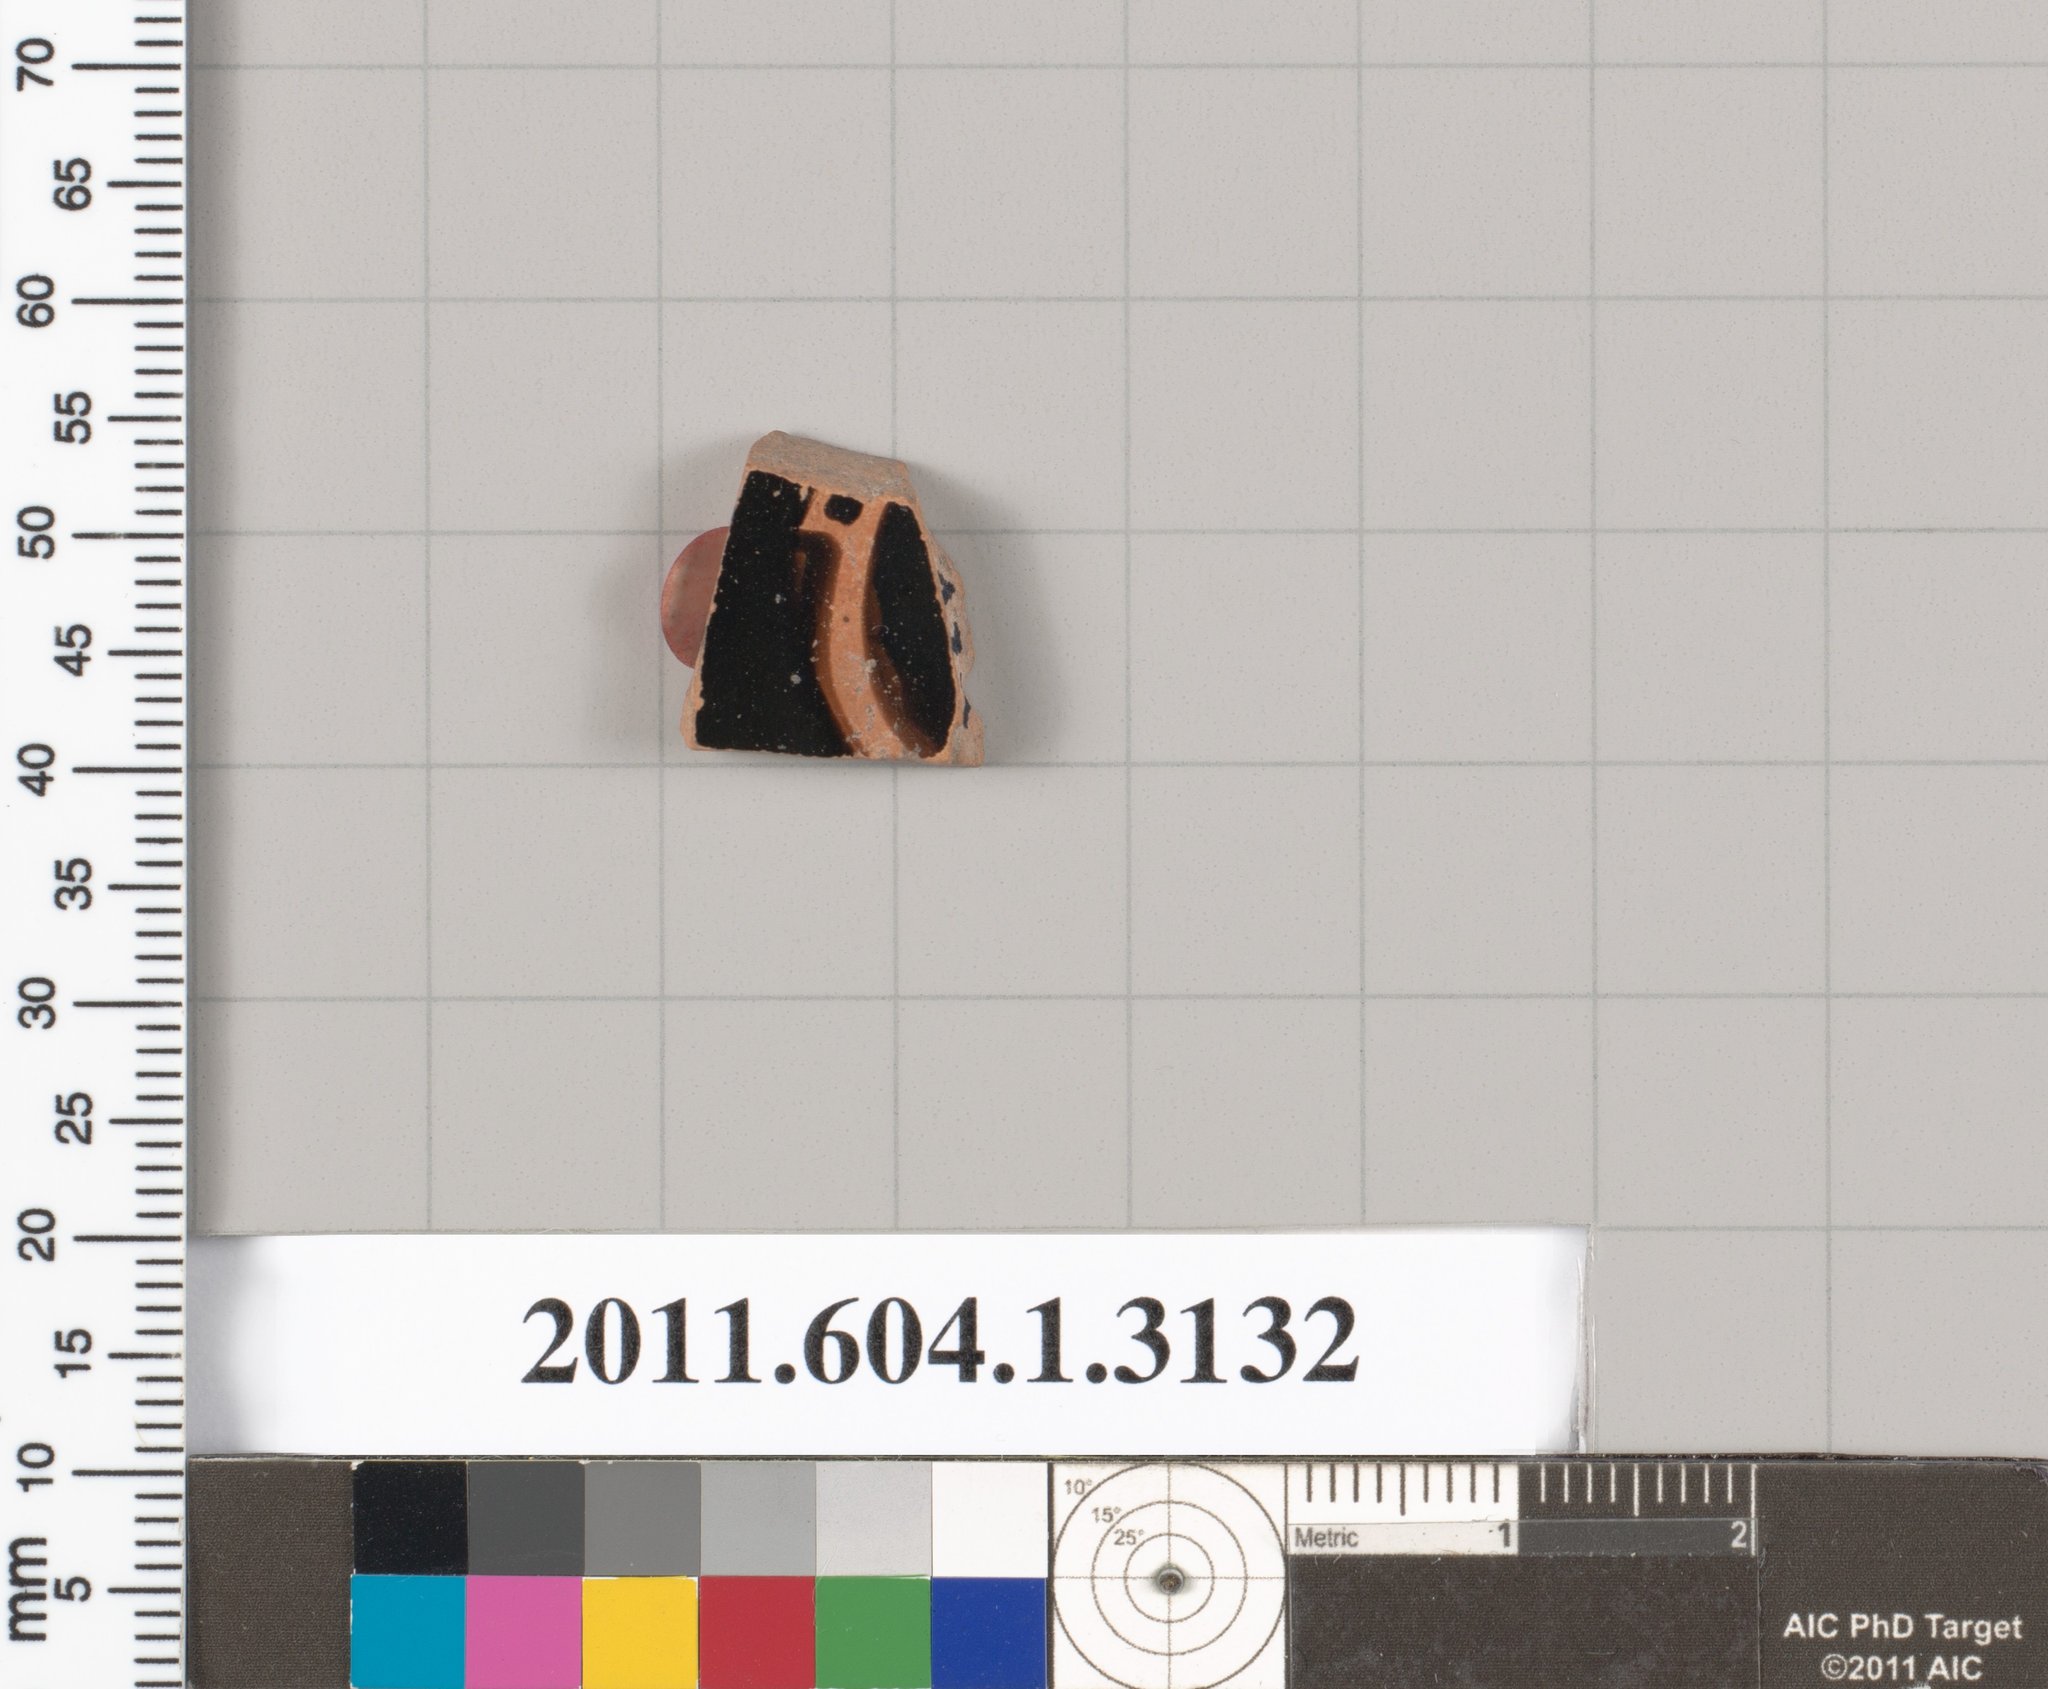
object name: kylix fragment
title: Terracotta fragment of a kylix (drinking cup)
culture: greek, attic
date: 500-451 BCE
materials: terracotta